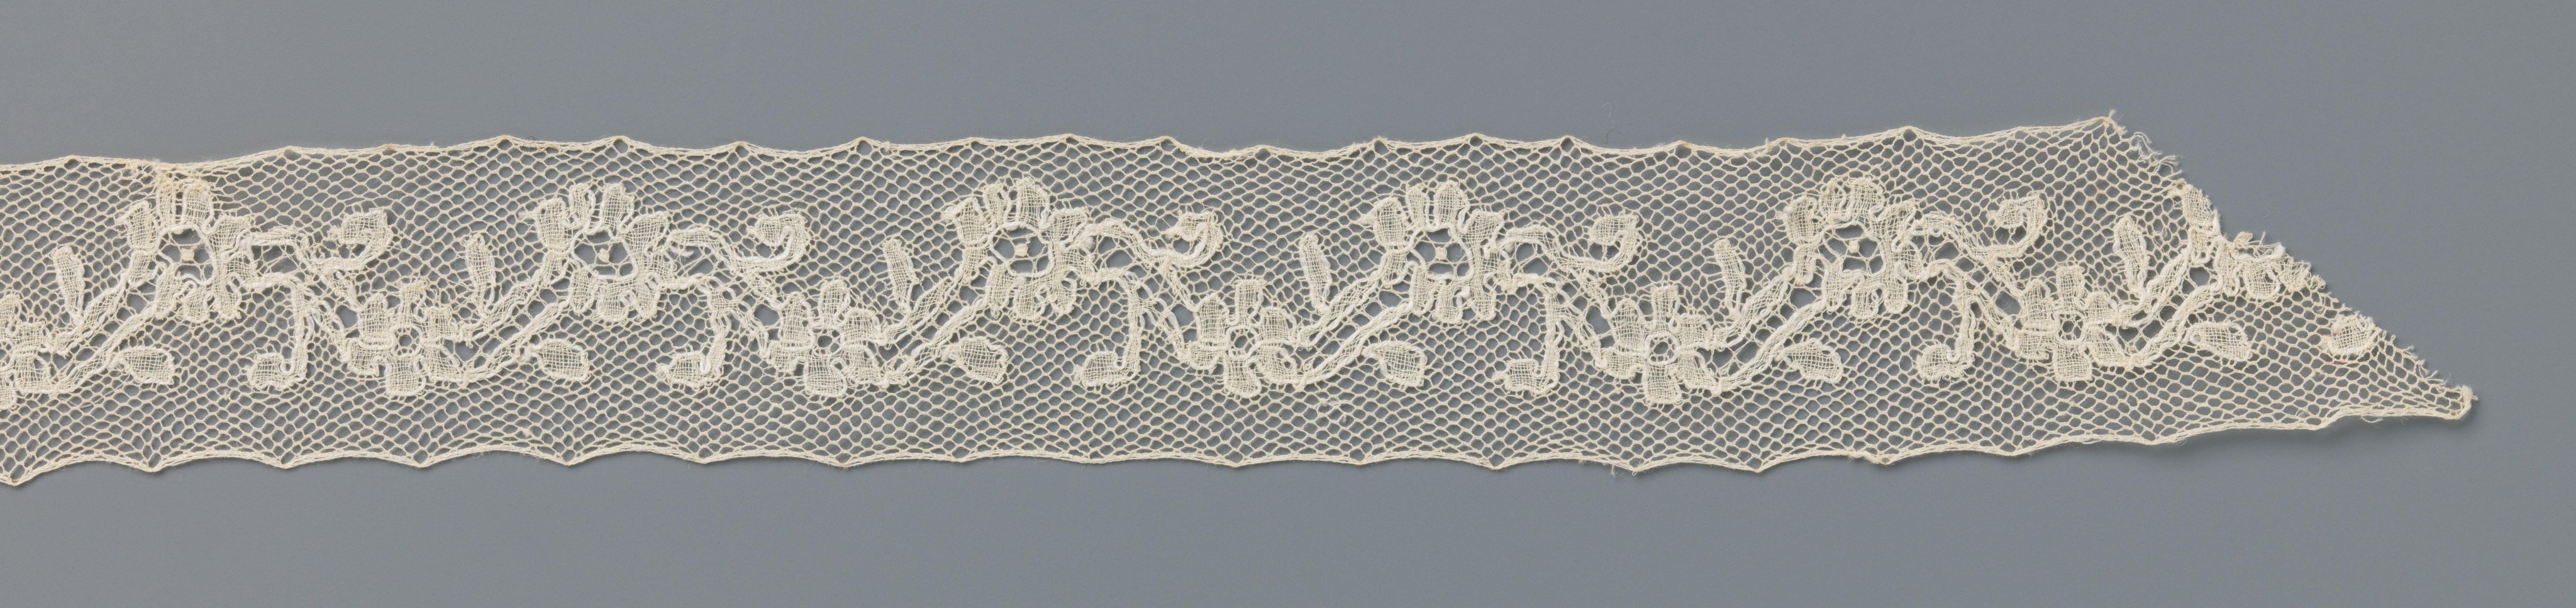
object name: entre deux, tussenzetsel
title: Tussenzetsel van kloskant met zigzaglijn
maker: Anonymous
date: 1875-1949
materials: linen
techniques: lace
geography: belgium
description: Tussenzetsel van naturelkleurige kloskant: Mechelse kant. In het midden van de fijne traliegrond, een Mechelse grond (ook wel ijsgrond genoemd), loopt een opengewerkte band in zigzaglijn, oversneden door twee soorten rozetjes.